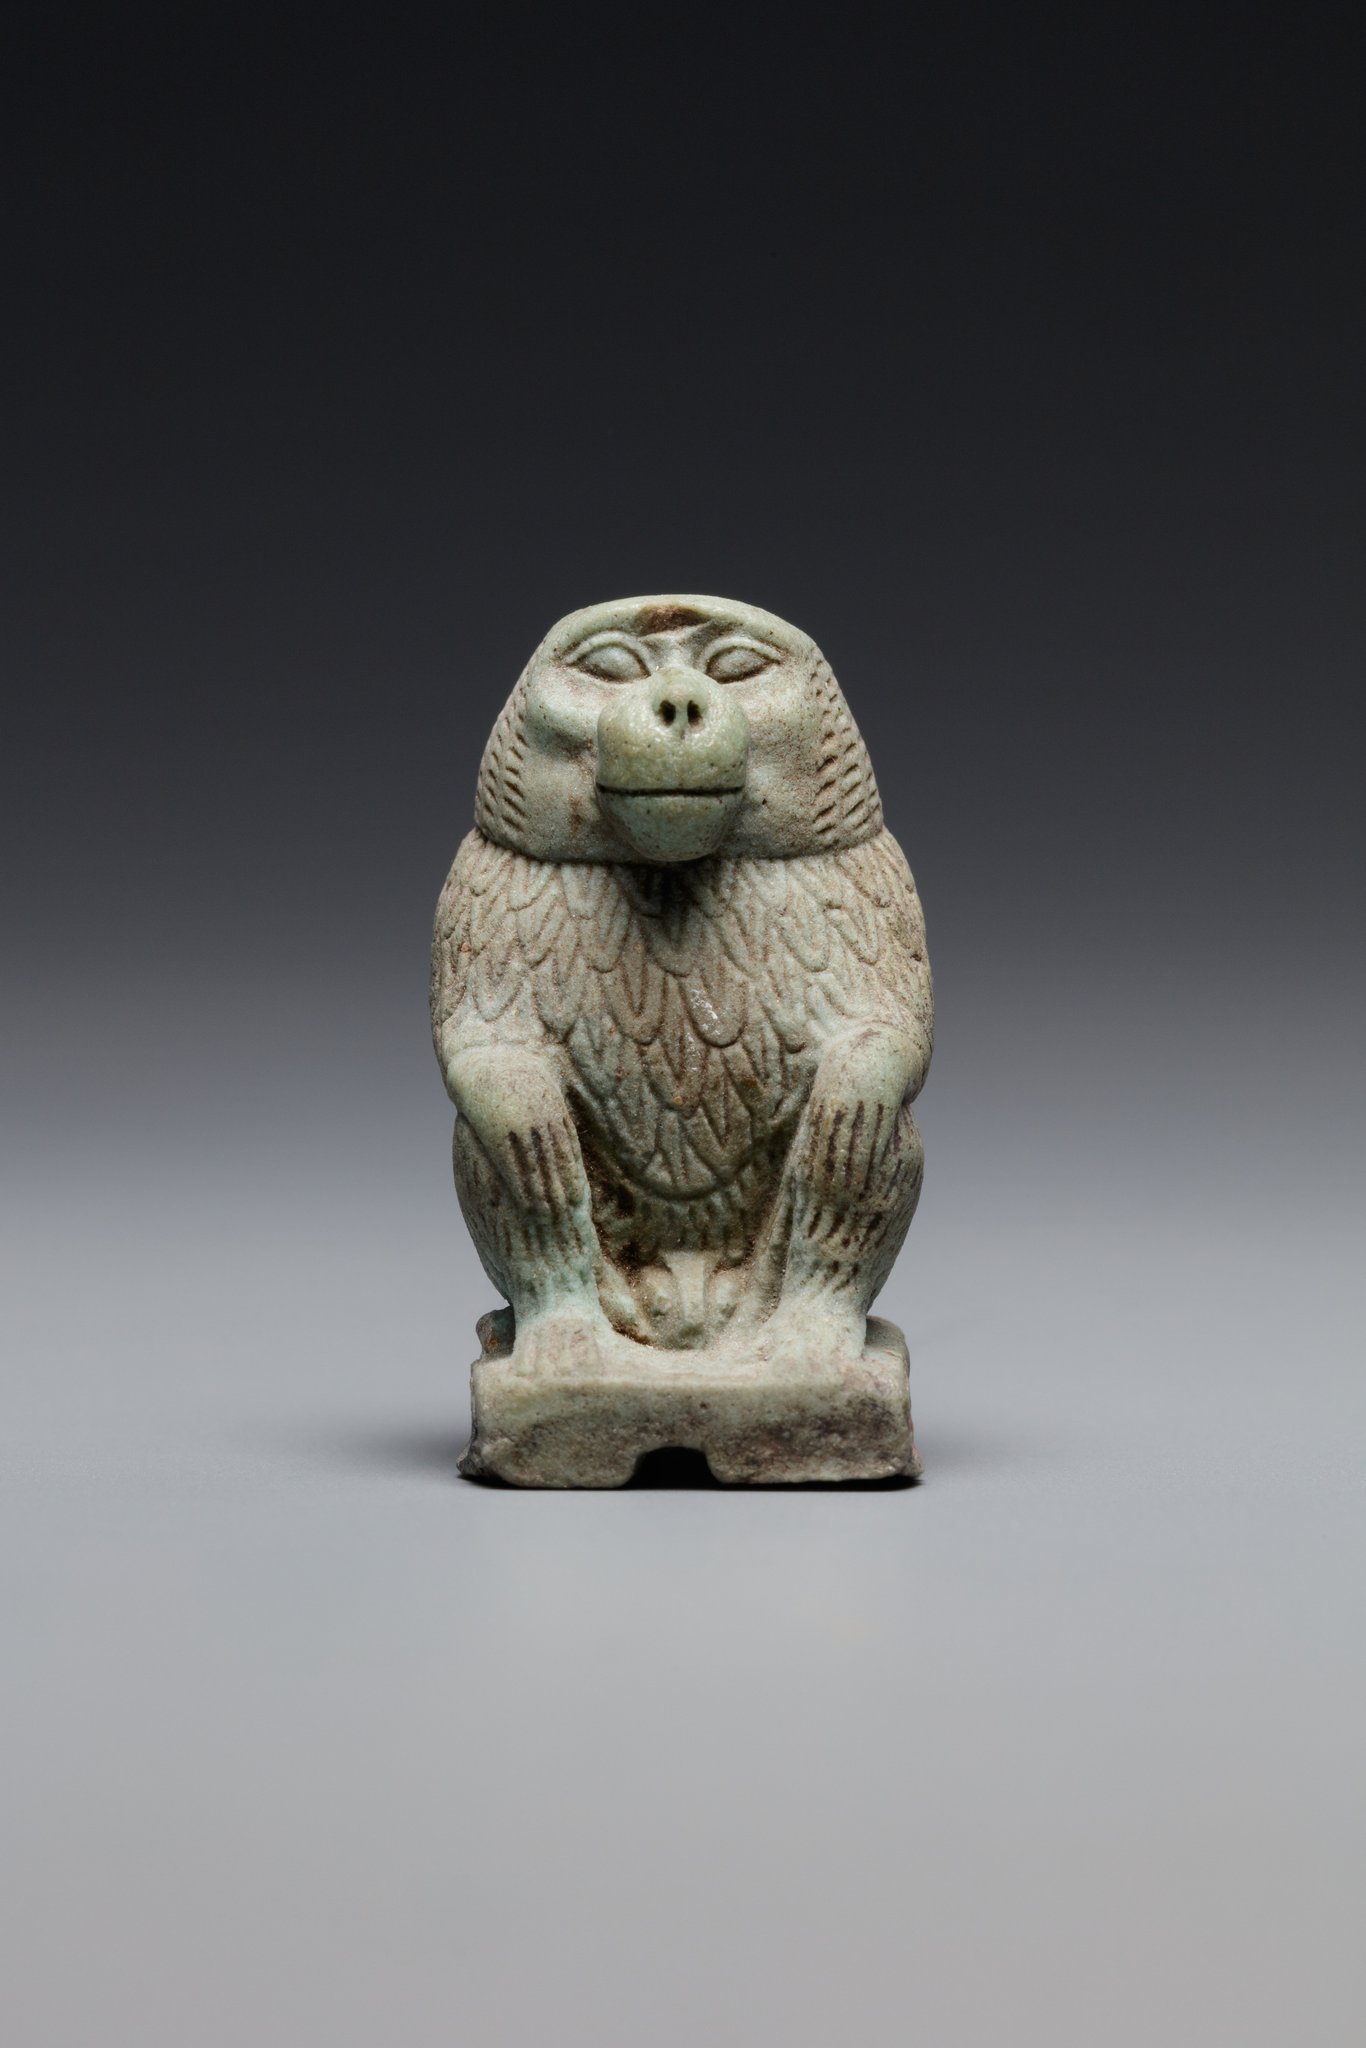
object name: amulet, baboon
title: Amulet: Squatting Baboon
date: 664-332 BCE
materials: faience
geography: egypt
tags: baboons